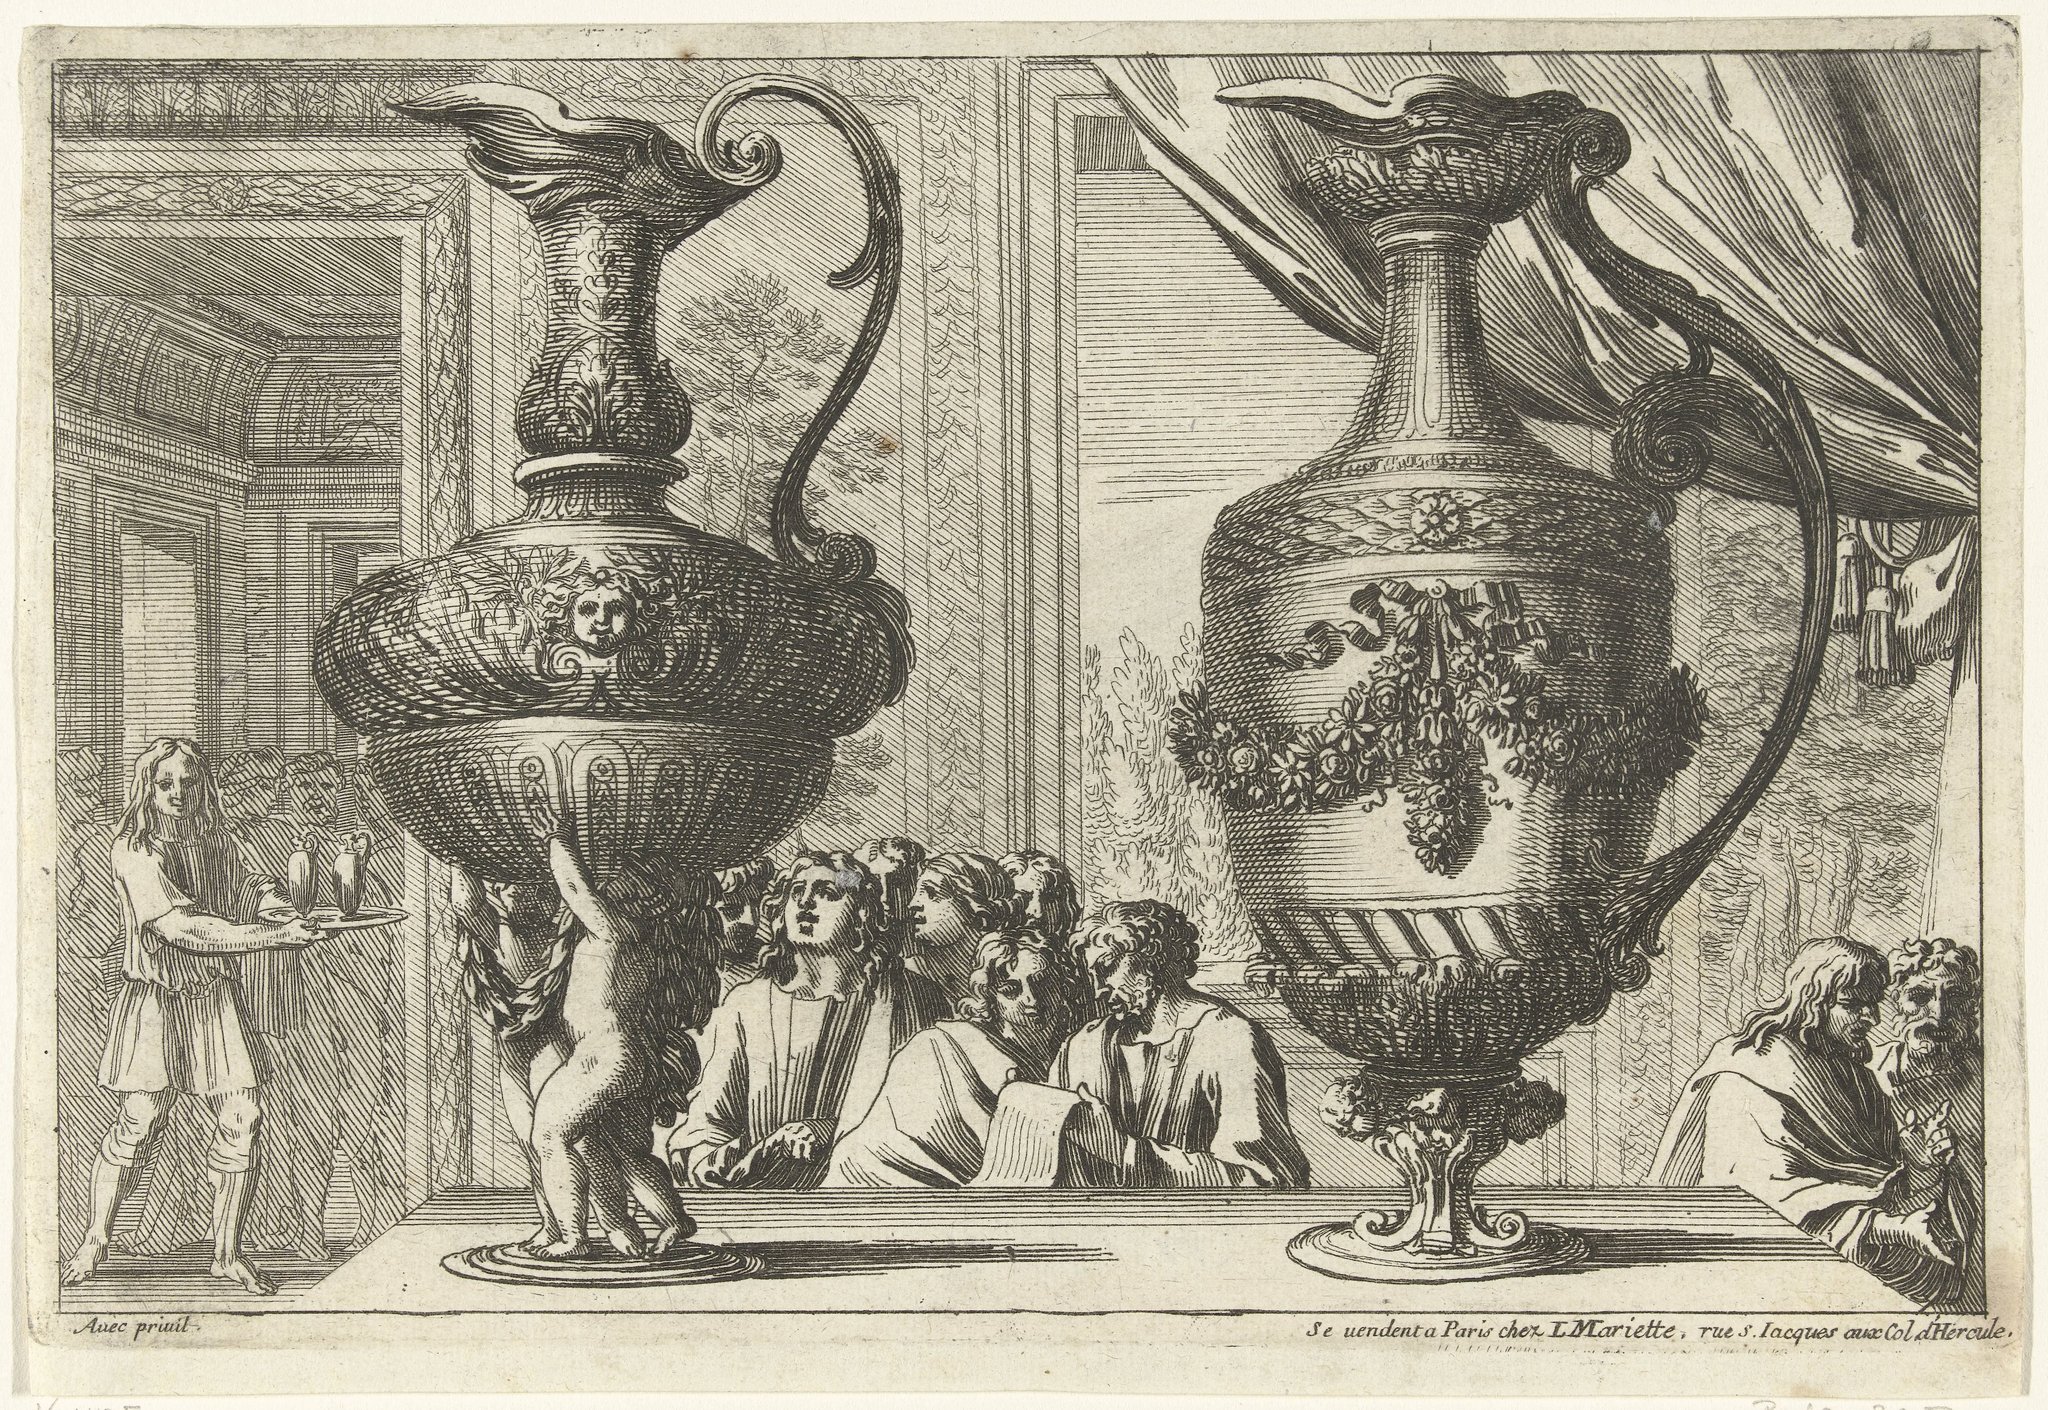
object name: ornament print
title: Twee schenkkannen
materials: paper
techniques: etching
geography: france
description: De schenkkan links staat op een voet gevormd door twee putti. Blad 4 uit serie van 6 bladen, derde editie.